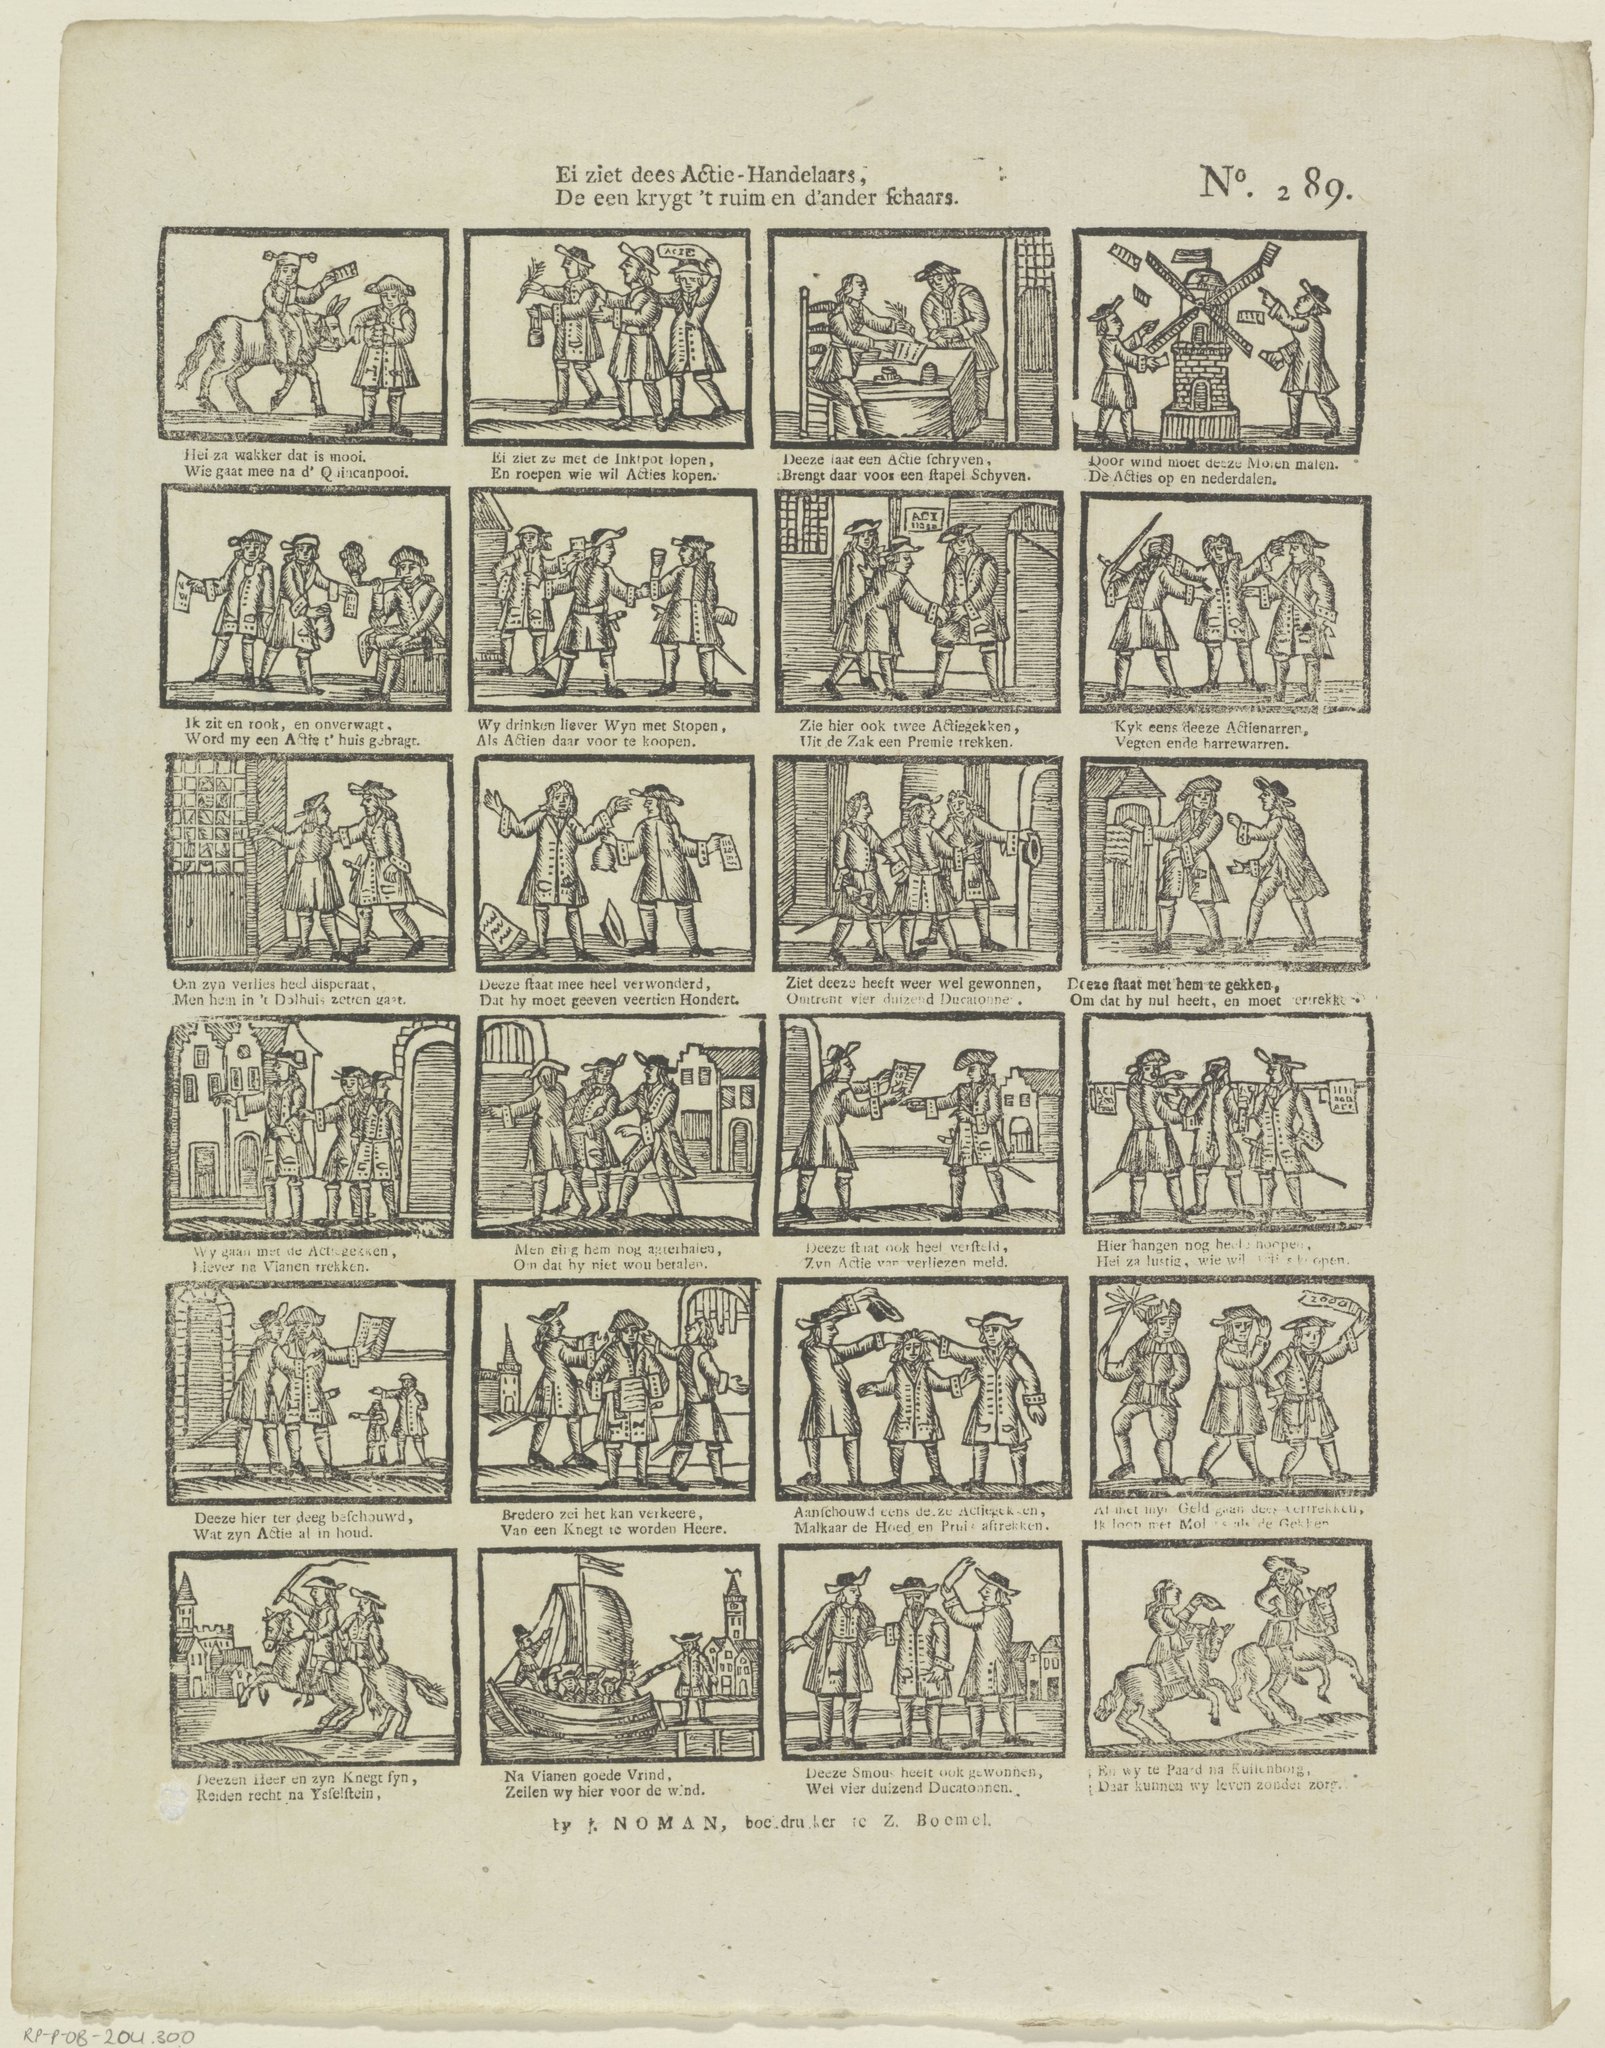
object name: print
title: Ei ziet dees actie-handelaars, / De een krygt 't ruin en d'ander schaars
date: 1806-1830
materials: paper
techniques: letterpress printing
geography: zaltbommel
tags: stock exchange, stock-market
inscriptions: collector's mark: Lugt 2760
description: Blad met 24 voorstellingen van actiehandelaren (aandelenhandelaren) in actie. Onder elke afbeelding een tweeregelig vers. Genummerd rechtsboven: No. 289.